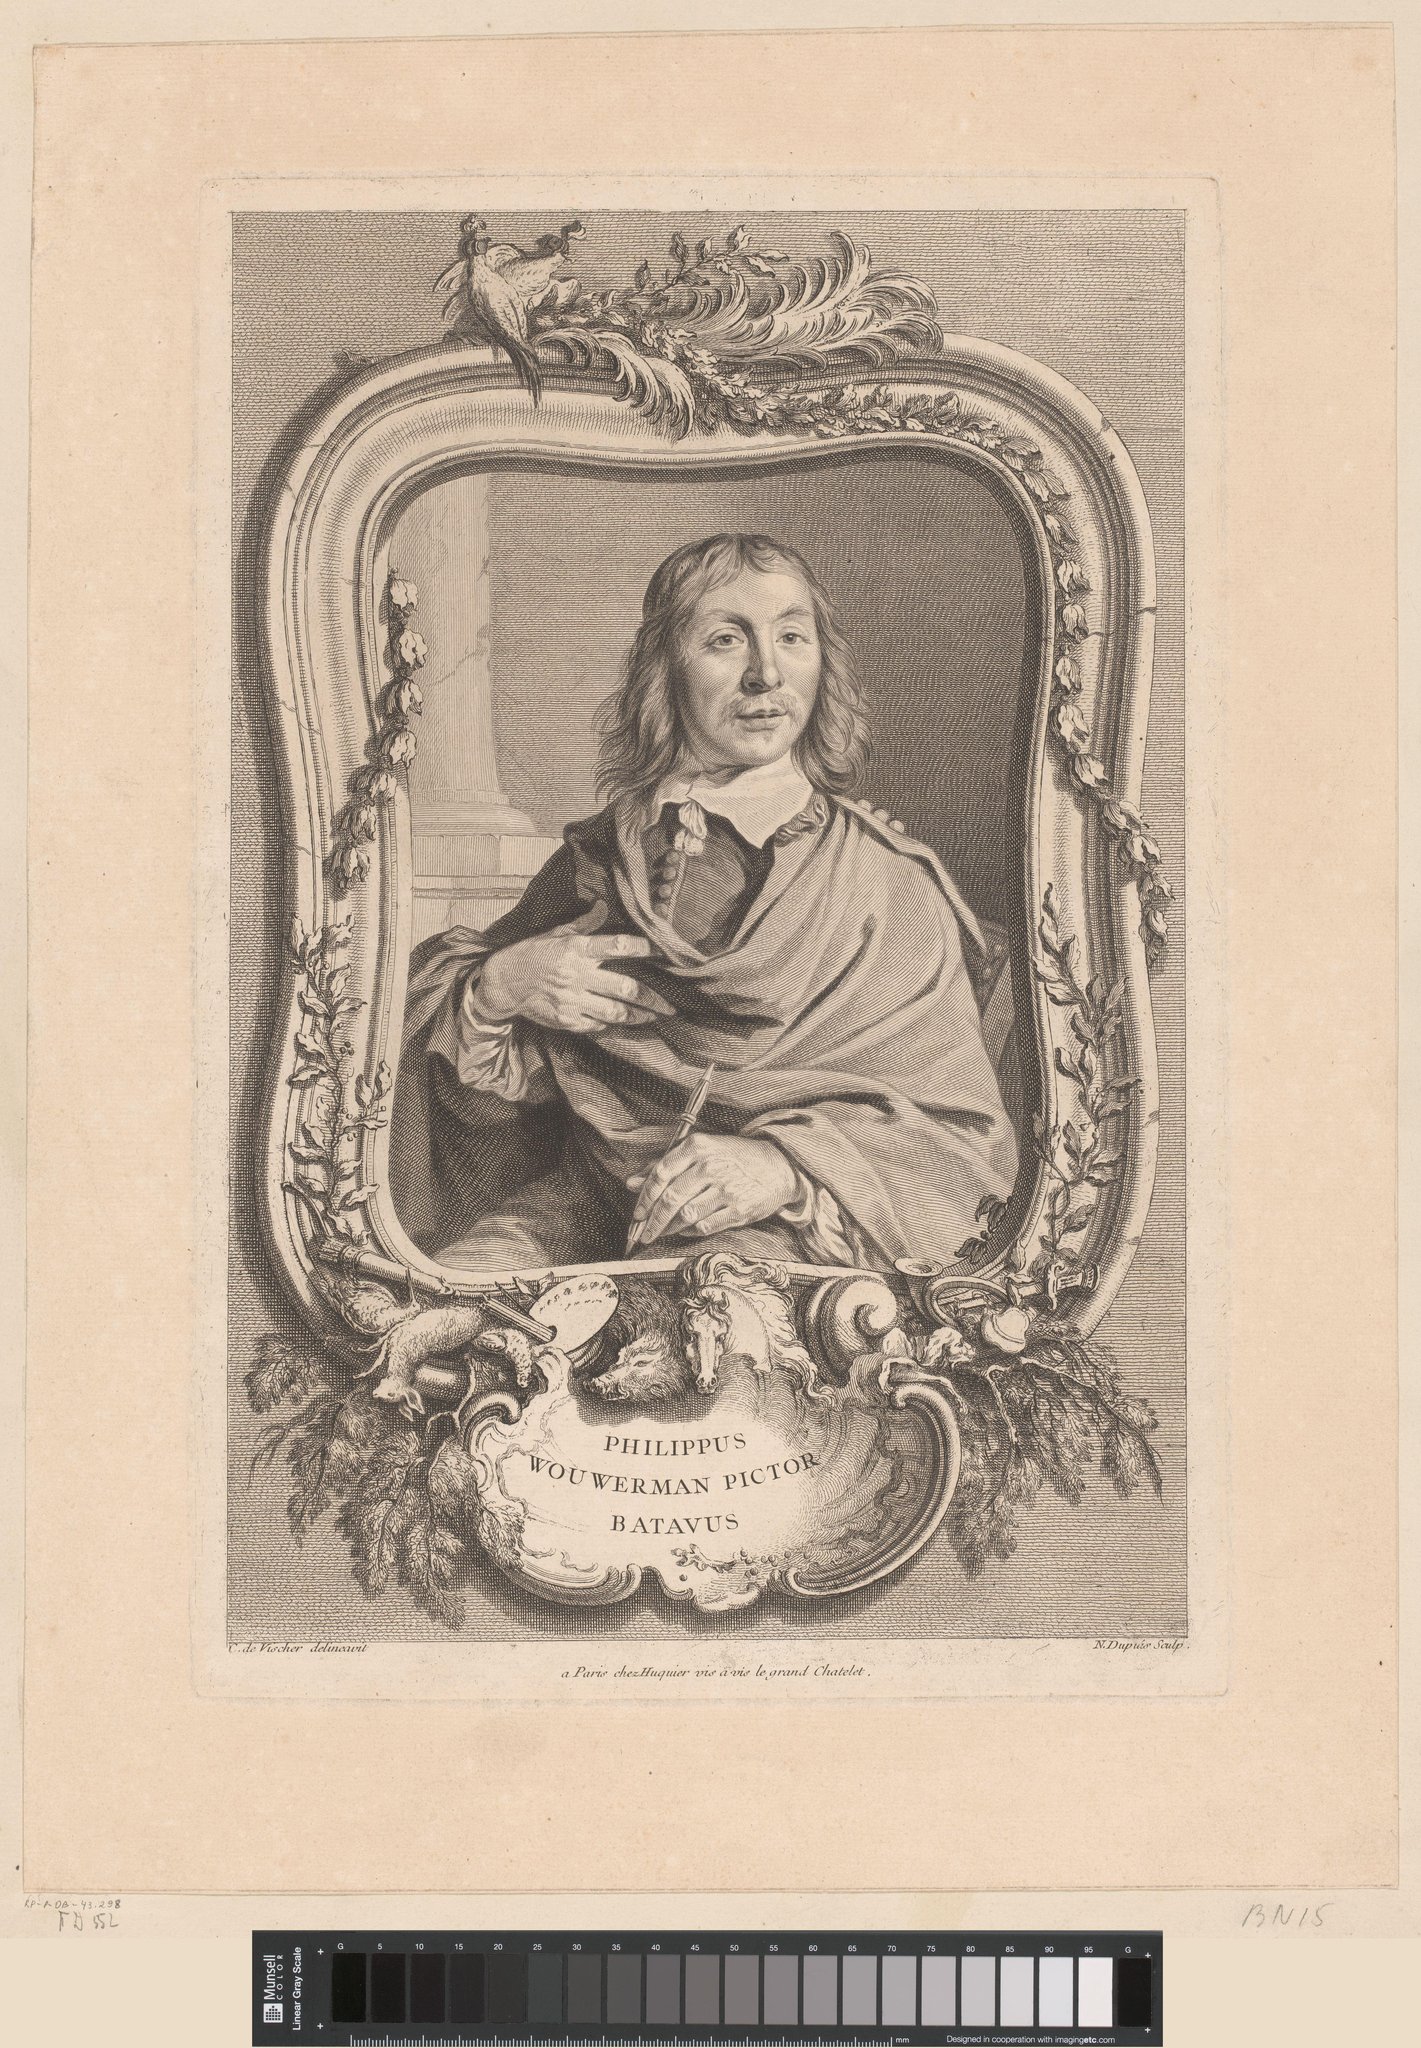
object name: print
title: Portret van Philips Wouwerman in versierde lijst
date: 1734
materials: paper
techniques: engraving, etching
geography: paris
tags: haarlem, painter, philips wouwerman, portrait, self-portrait of painter, frame of painting, etc.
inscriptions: collector's mark: Lugt 240